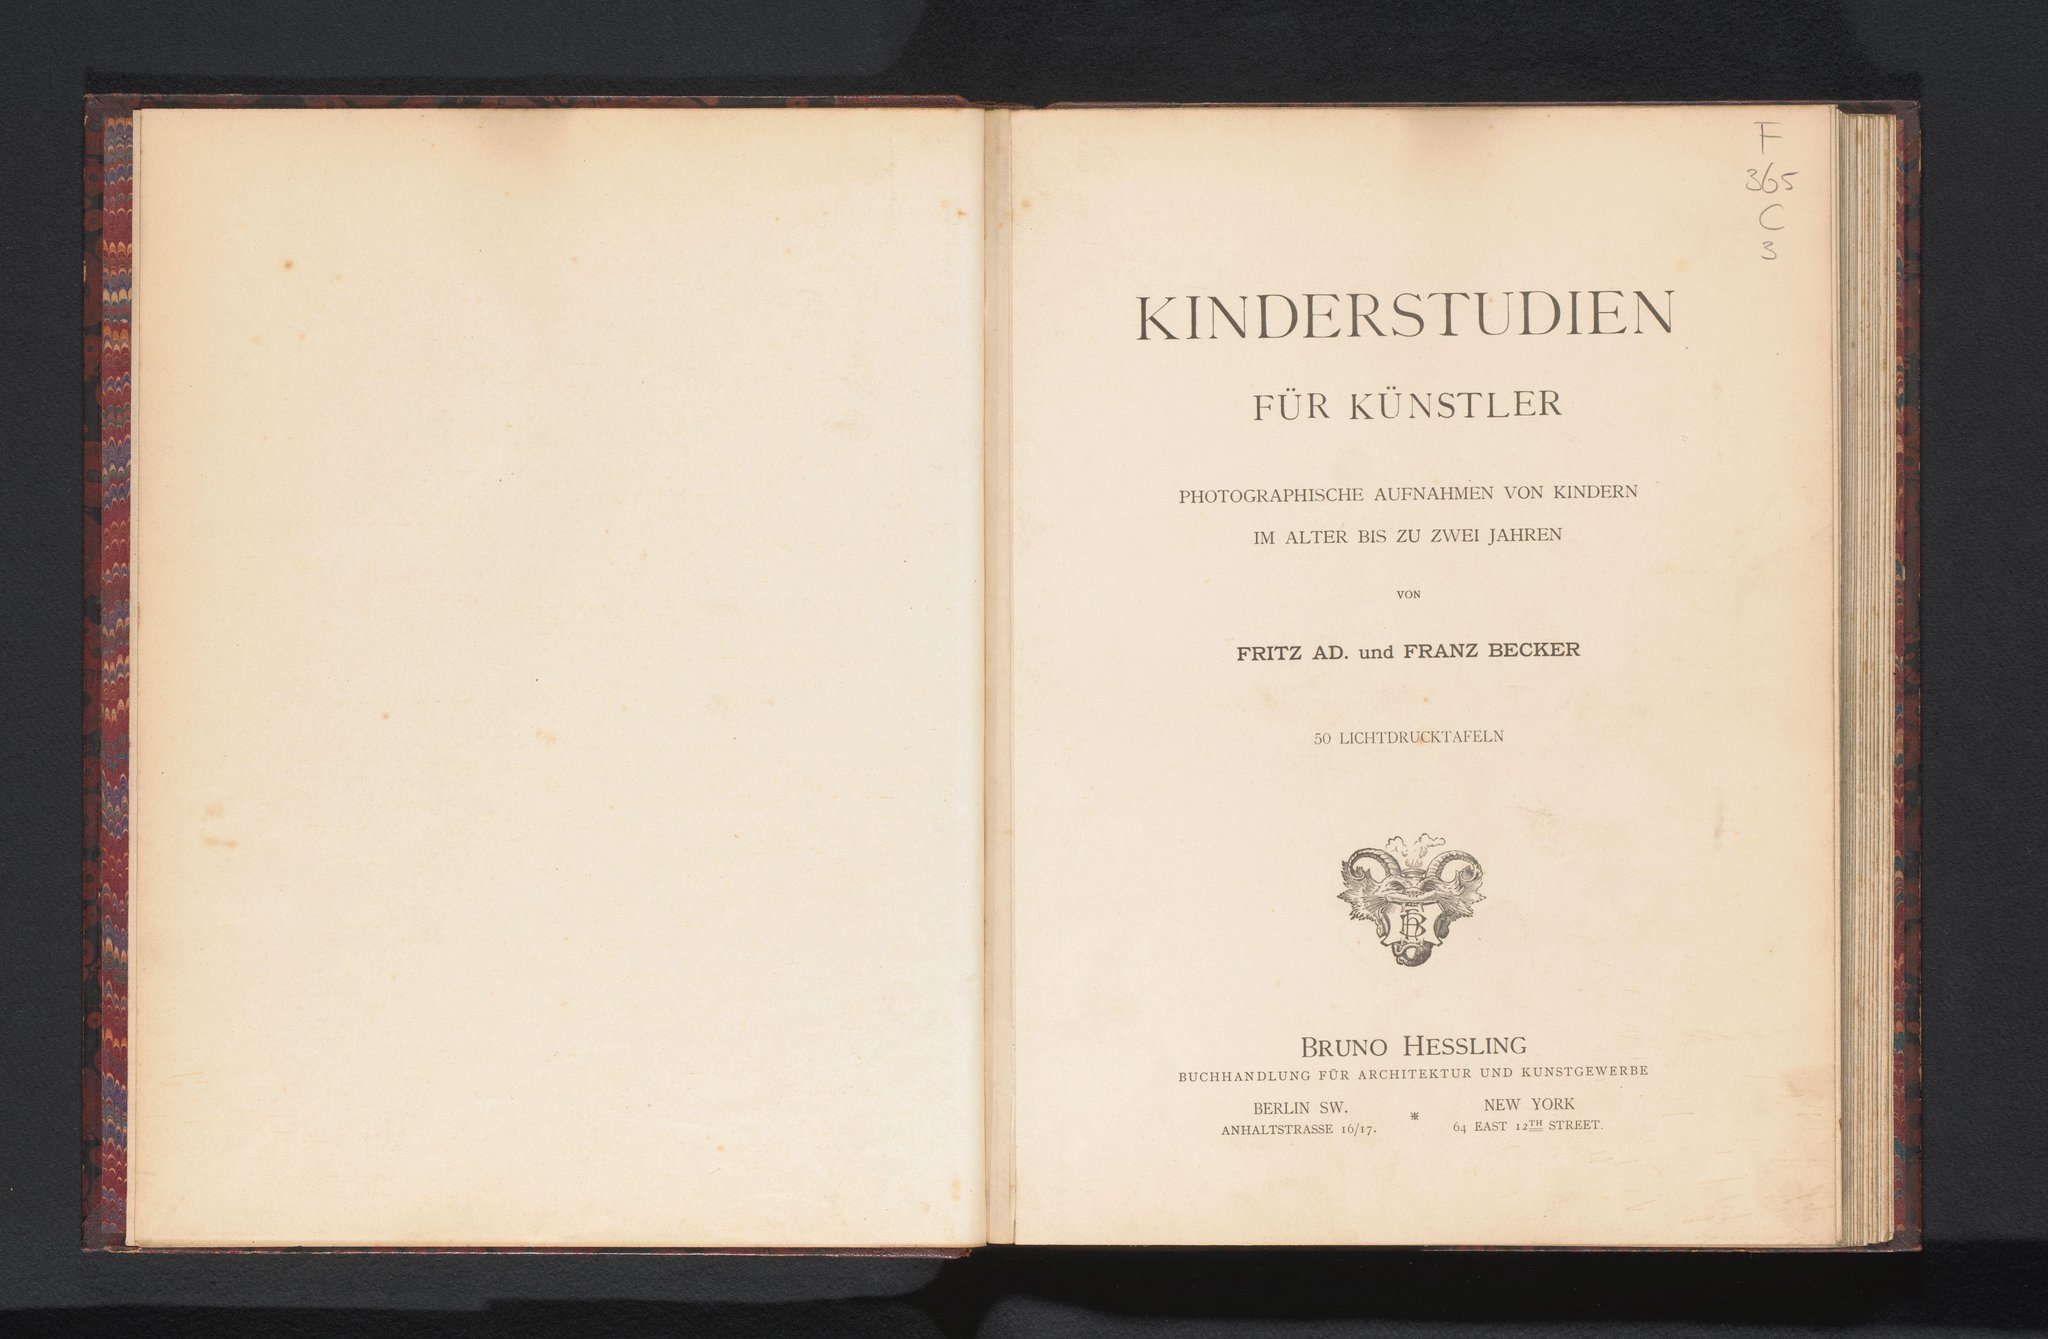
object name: book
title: Kinderstudien für Künstler : photographische Aufnahmen von Kindern im Alter bis zu zwei Jahren / von Fritz Ad. und Franz Becker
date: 1903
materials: cardboard, leather, linen, paper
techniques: photograph, marbled paper, printing, marbling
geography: berlin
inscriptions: date: ‘AUG/ 1998’